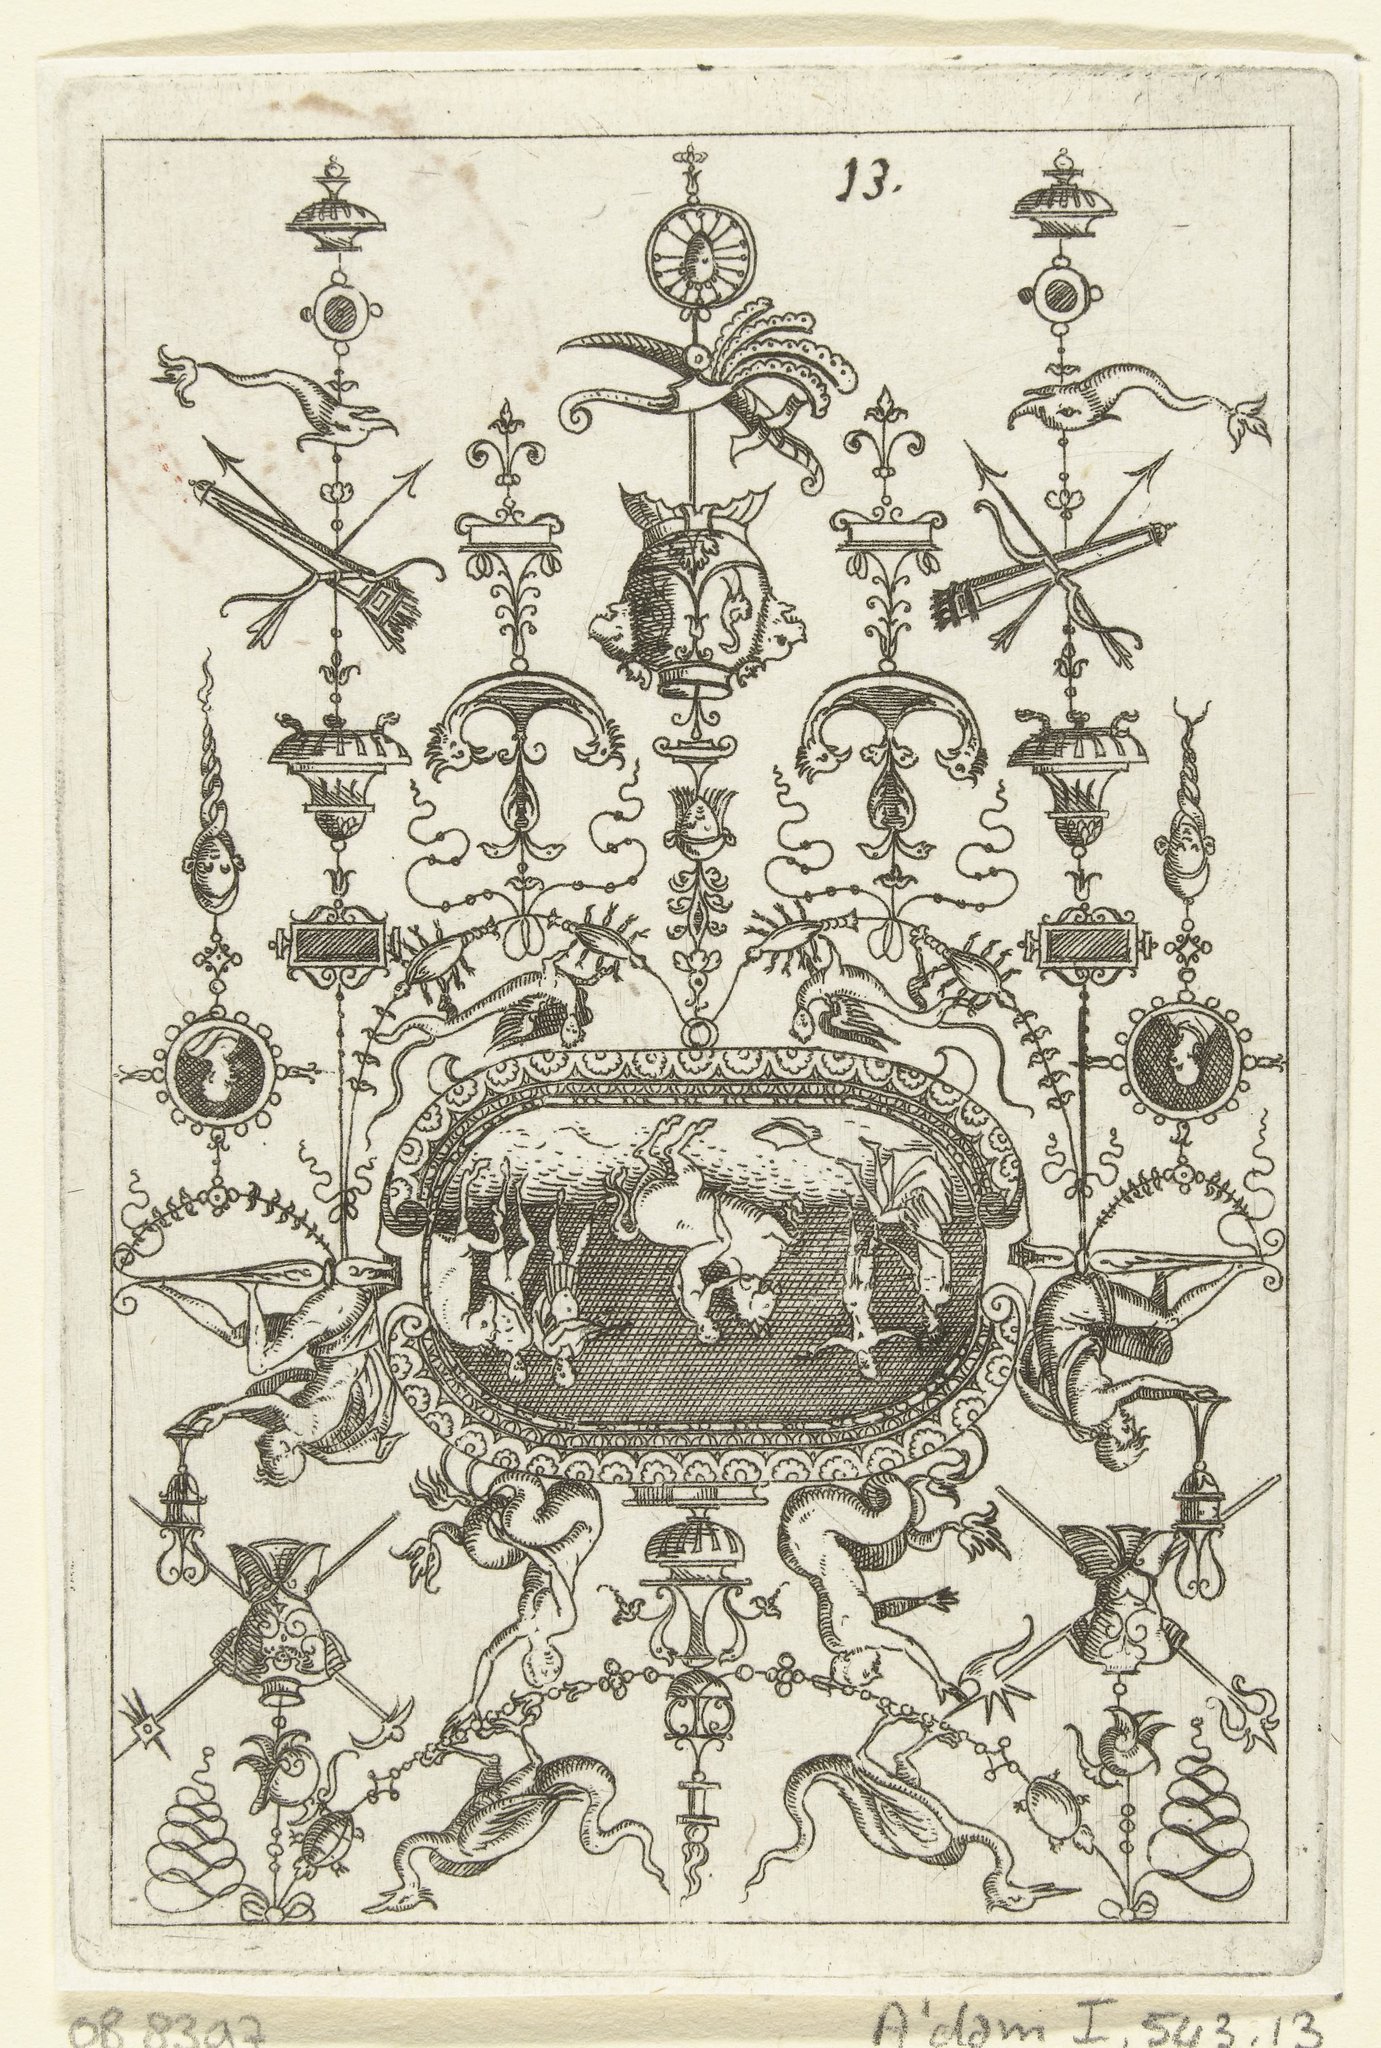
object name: ornament print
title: Iacobus Androuetius Du Cerceau inventor ante annos non paucos conscripsit (...)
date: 1525-1594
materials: paper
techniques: etching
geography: germany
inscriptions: collector's mark: Lugt 240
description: Blad uit serie met architectuurfantasieën en grotesken met fabelwezens, guirlandes, kandelabers en mascarons.